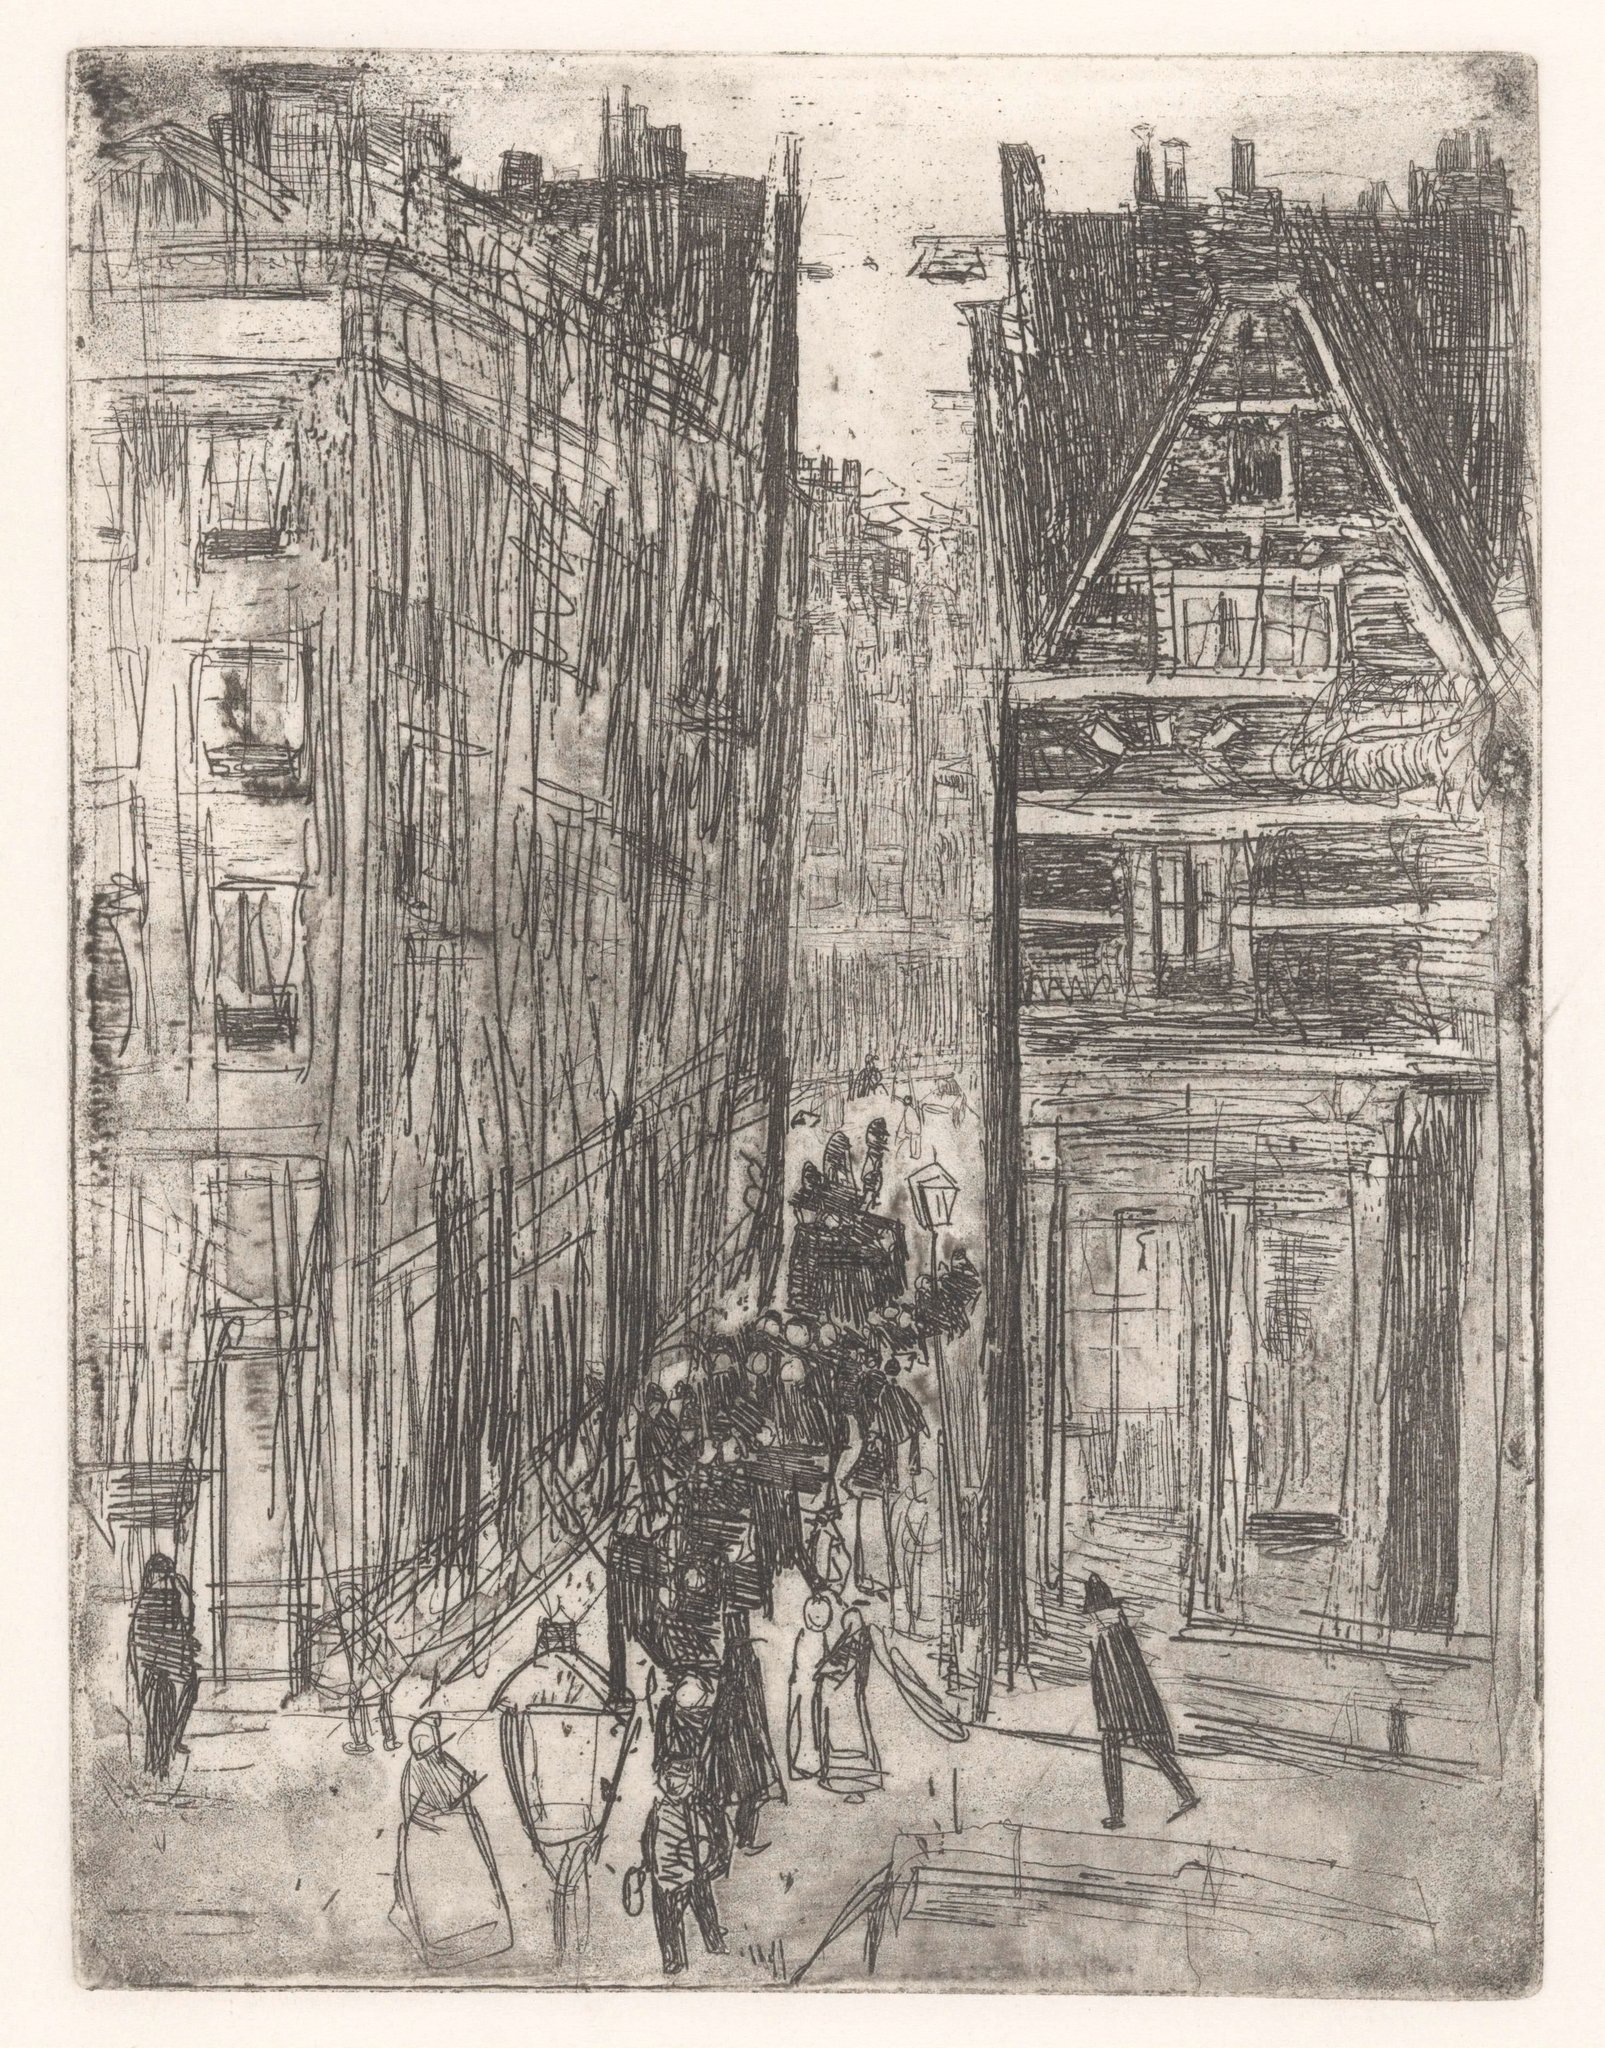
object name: print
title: Halvemaansteeg te Amsterdam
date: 1968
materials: paper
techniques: etching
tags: urban housing, lane, alley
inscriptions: collector's mark: Lugt 2228, : ‘door Op de Laak moderne afdruk plaat geschenk Mevr. Witjes 1968 Halvemaansteeg door Isaac Israëls’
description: Gasthuismolensteeg in Amsterdam, gezien vanuit Herengracht 232. In de steeg loopt een groep mensen.